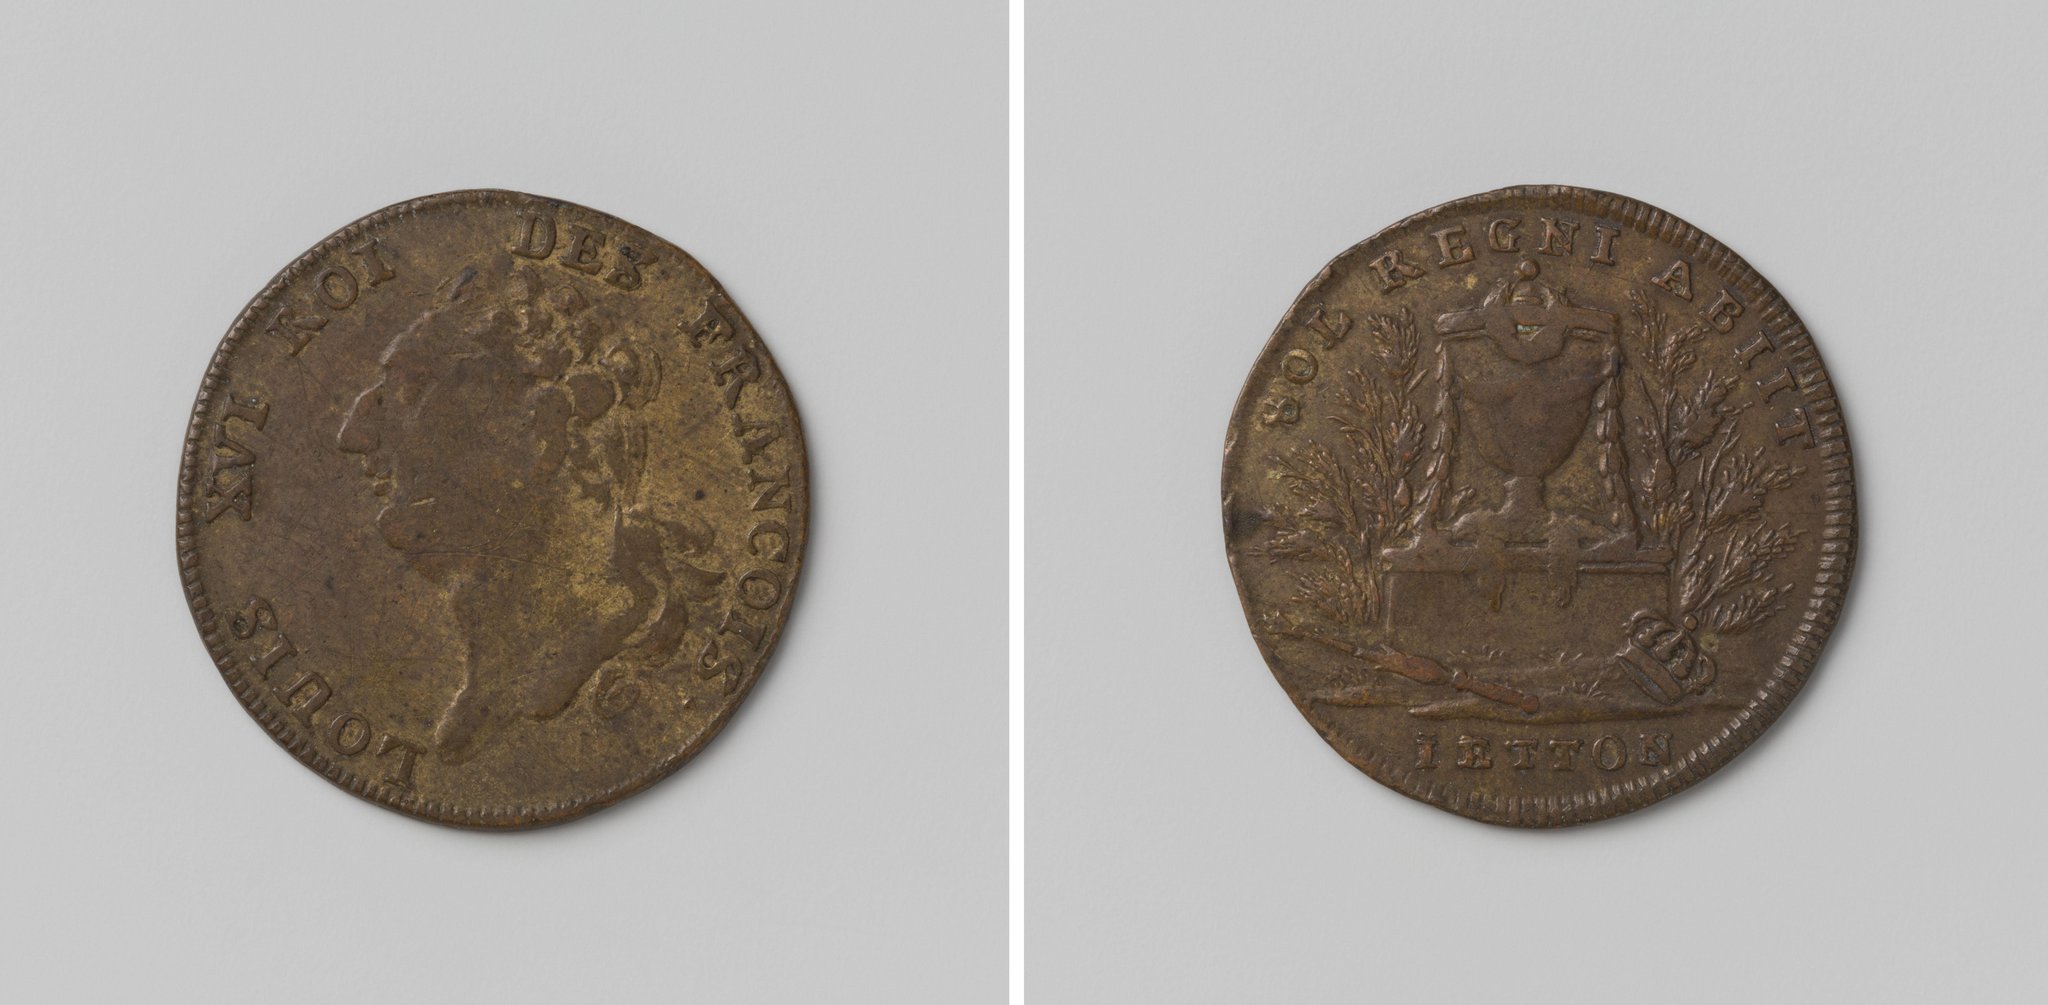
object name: jeton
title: Terechtstelling van Lodewijk XVI, koning van Frankrijk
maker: Anonymous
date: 1793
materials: brass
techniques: striking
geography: france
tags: paris, lodewijk xvi (koning van frankrijk)